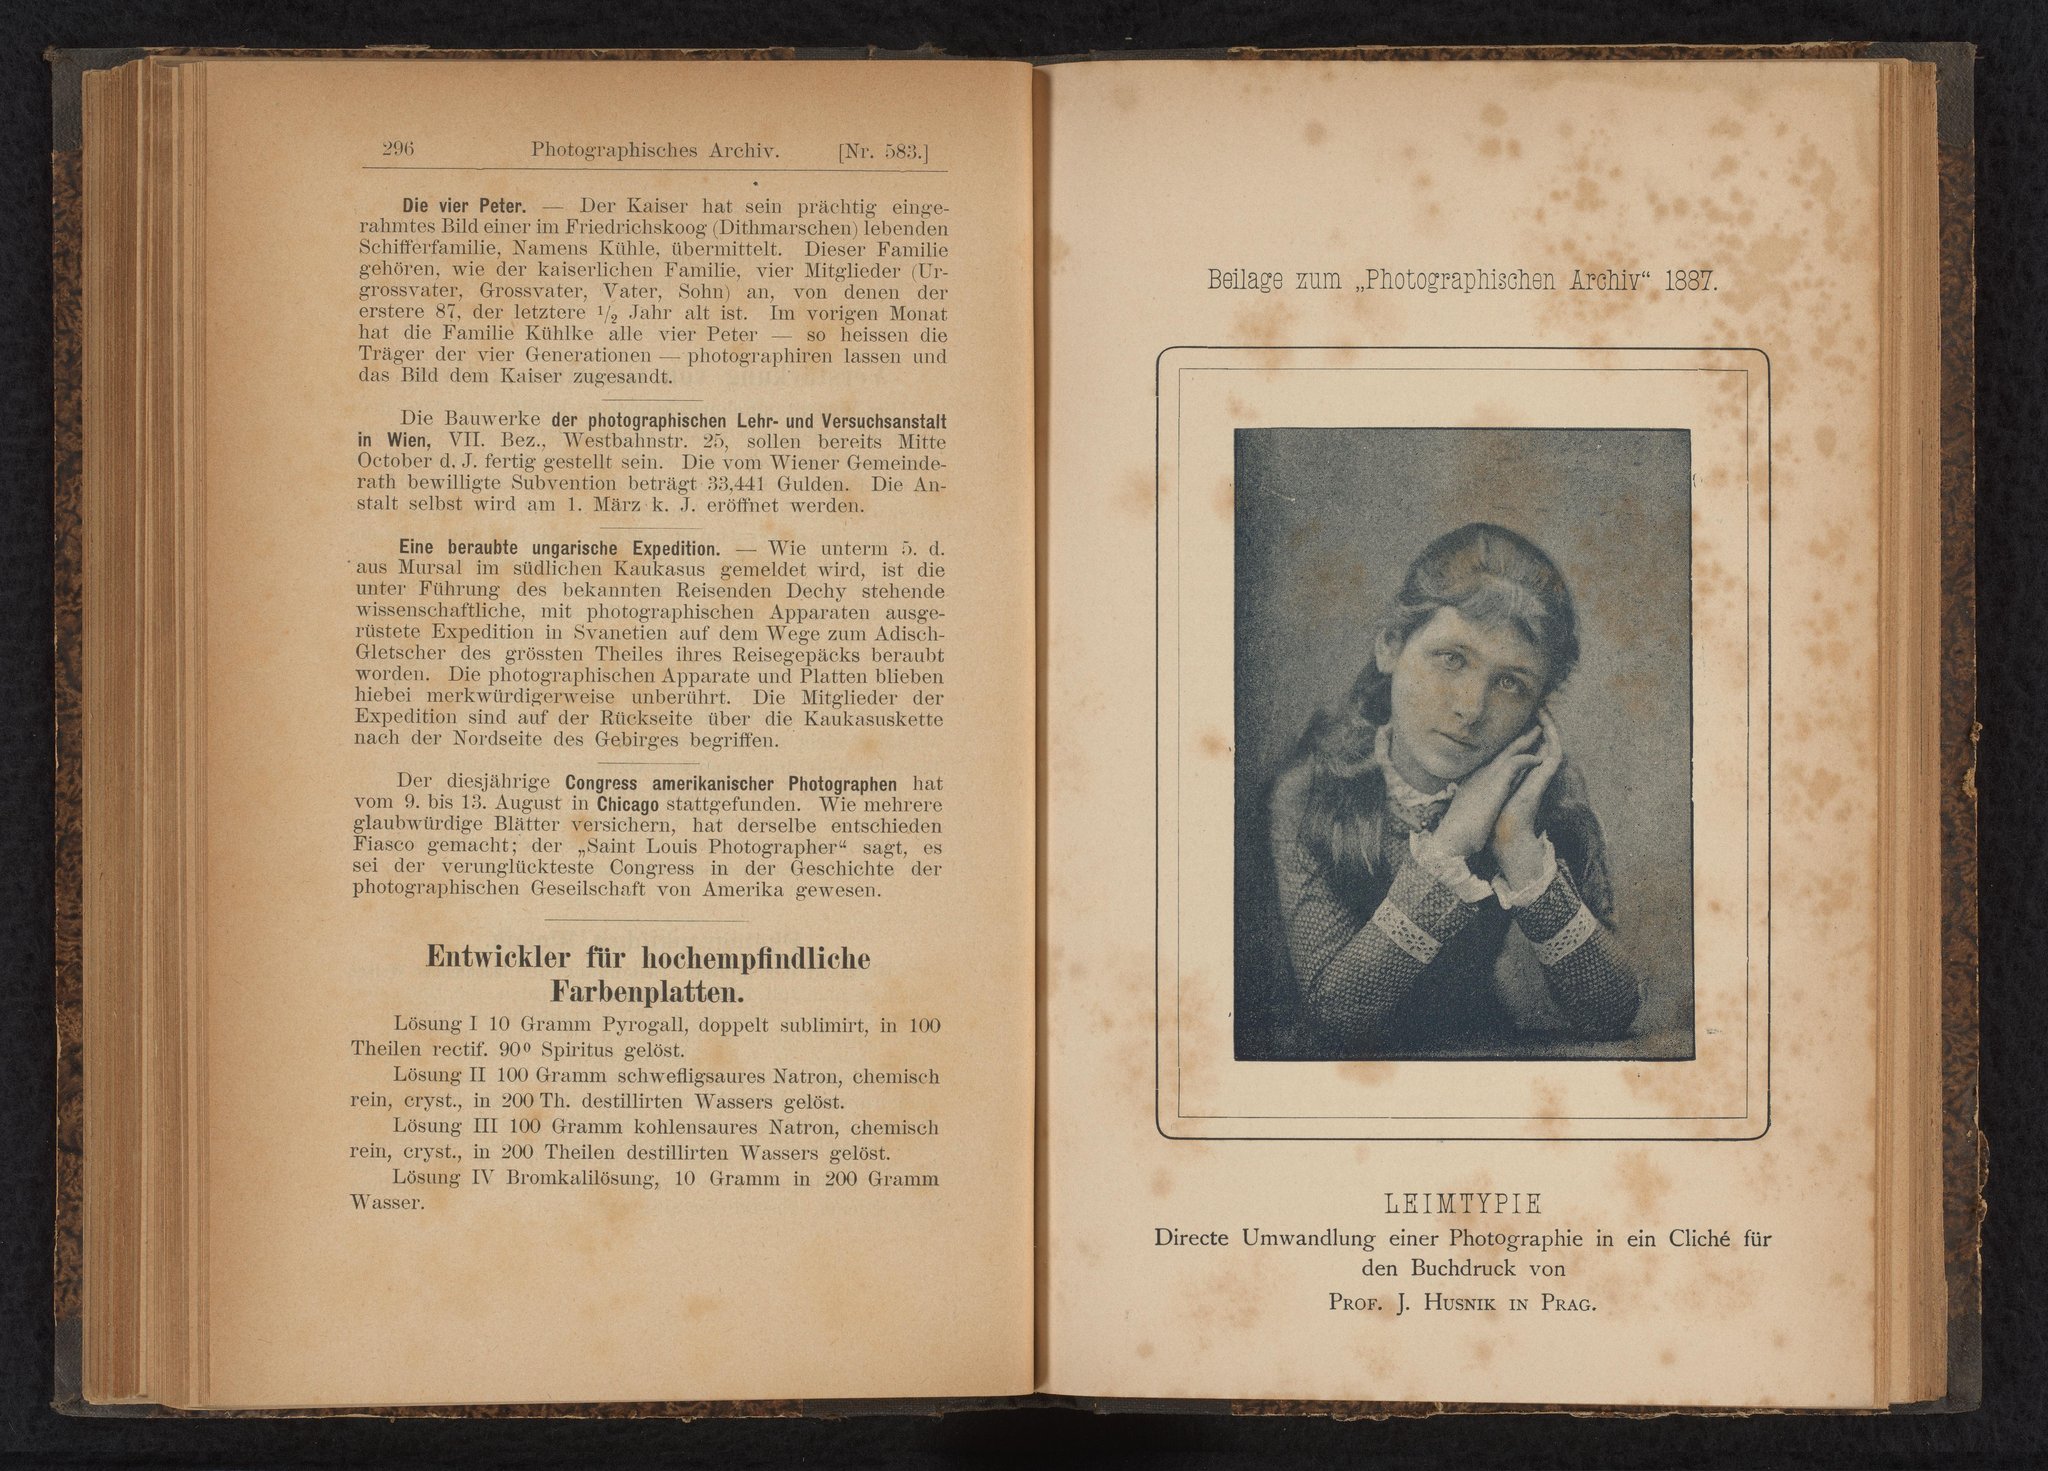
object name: page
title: Portret van een onbekend meisje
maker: jakub husnik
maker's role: clichémaker, fotograaf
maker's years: 1837-1916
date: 1882-1887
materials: paper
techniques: autotype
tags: historical persons not known by name - bb - woman, girl (child between toddler and youth)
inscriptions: inscription: ‘Leimtypie/ Directe Umwandlung einer Photographie in ein Cliché für/ den Buchdruck von/ Prof. J. Husnik in Prag.’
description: Prent op ongenummerd pagina tegenover pagina 296.